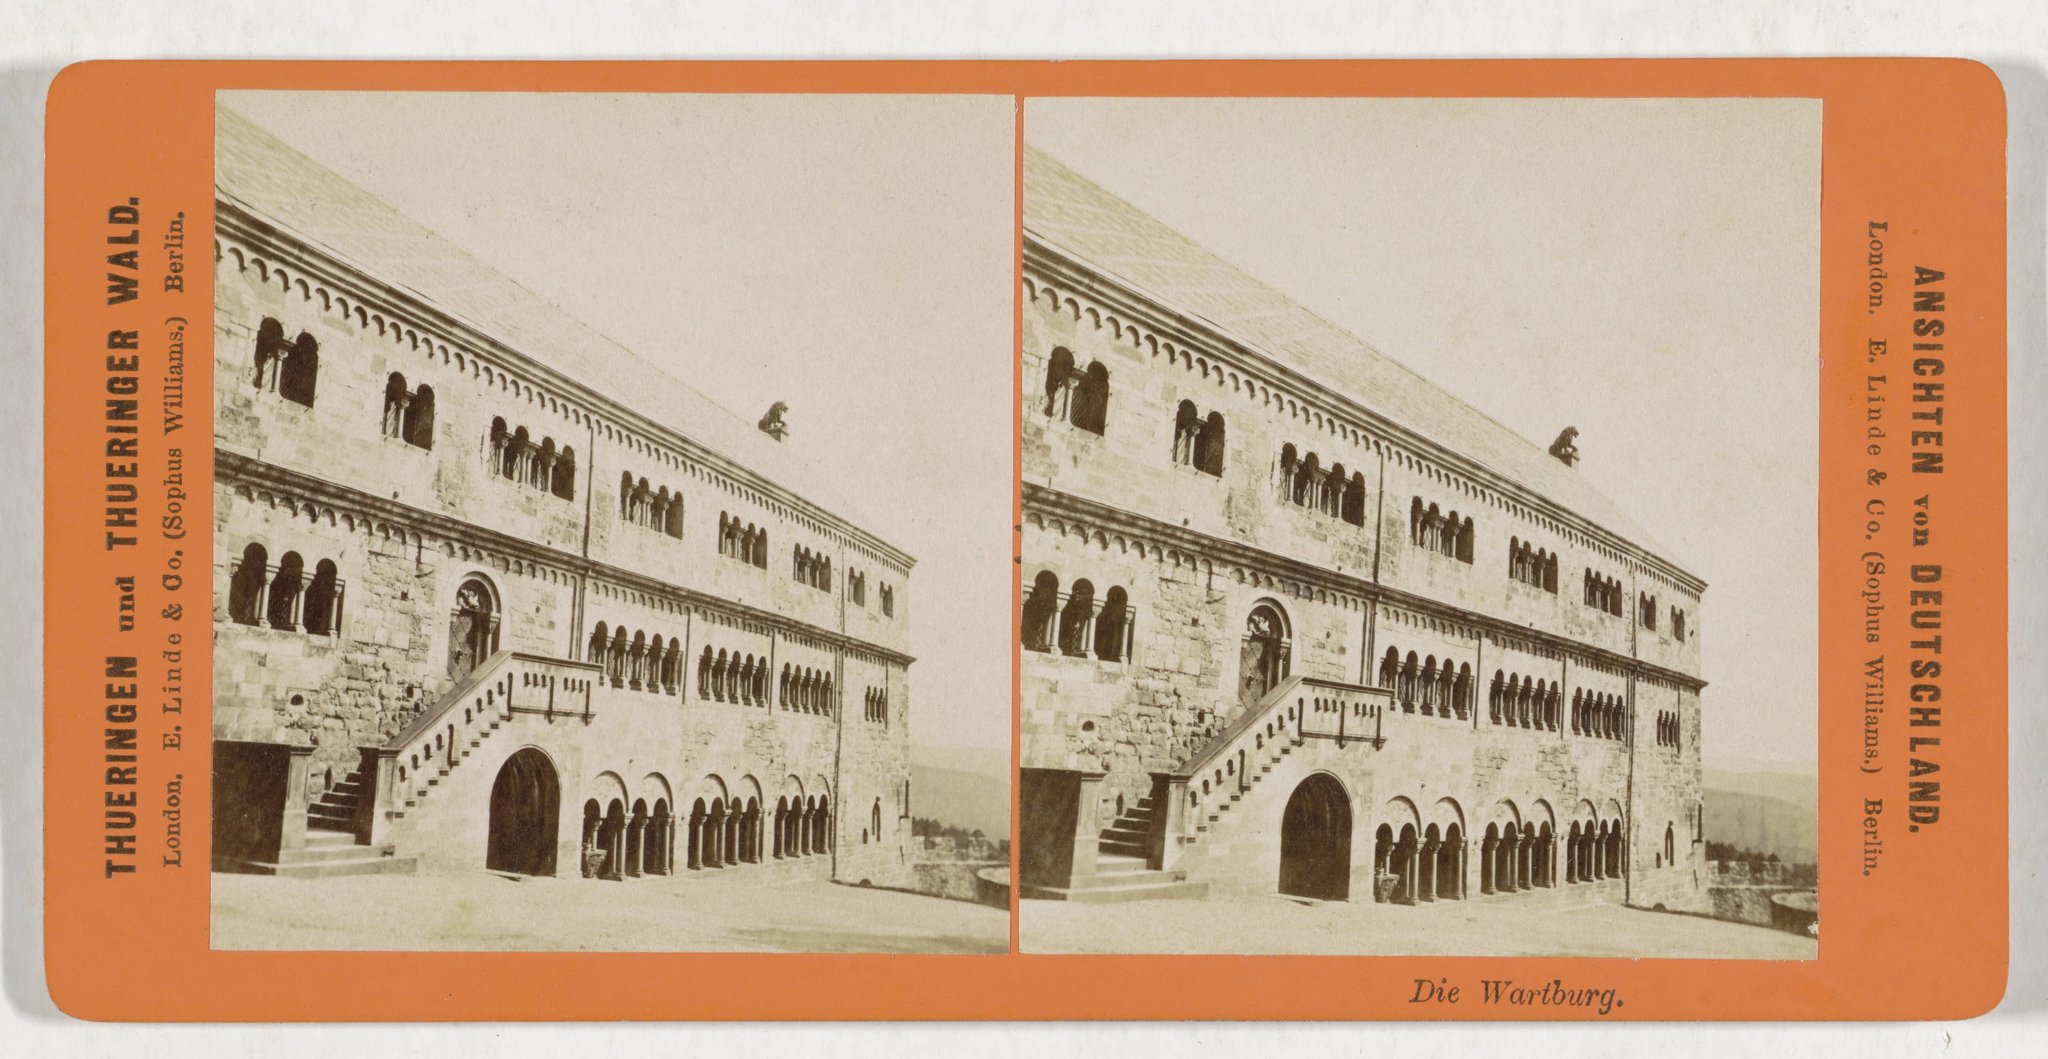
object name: stereograph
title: Paleis van de graven op de Wartburg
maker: hermann selle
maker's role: fotograaf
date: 1868-1890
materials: cardboard, paper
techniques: albumen print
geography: london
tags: palace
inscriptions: inscription: ‘Landgrafenhaus’